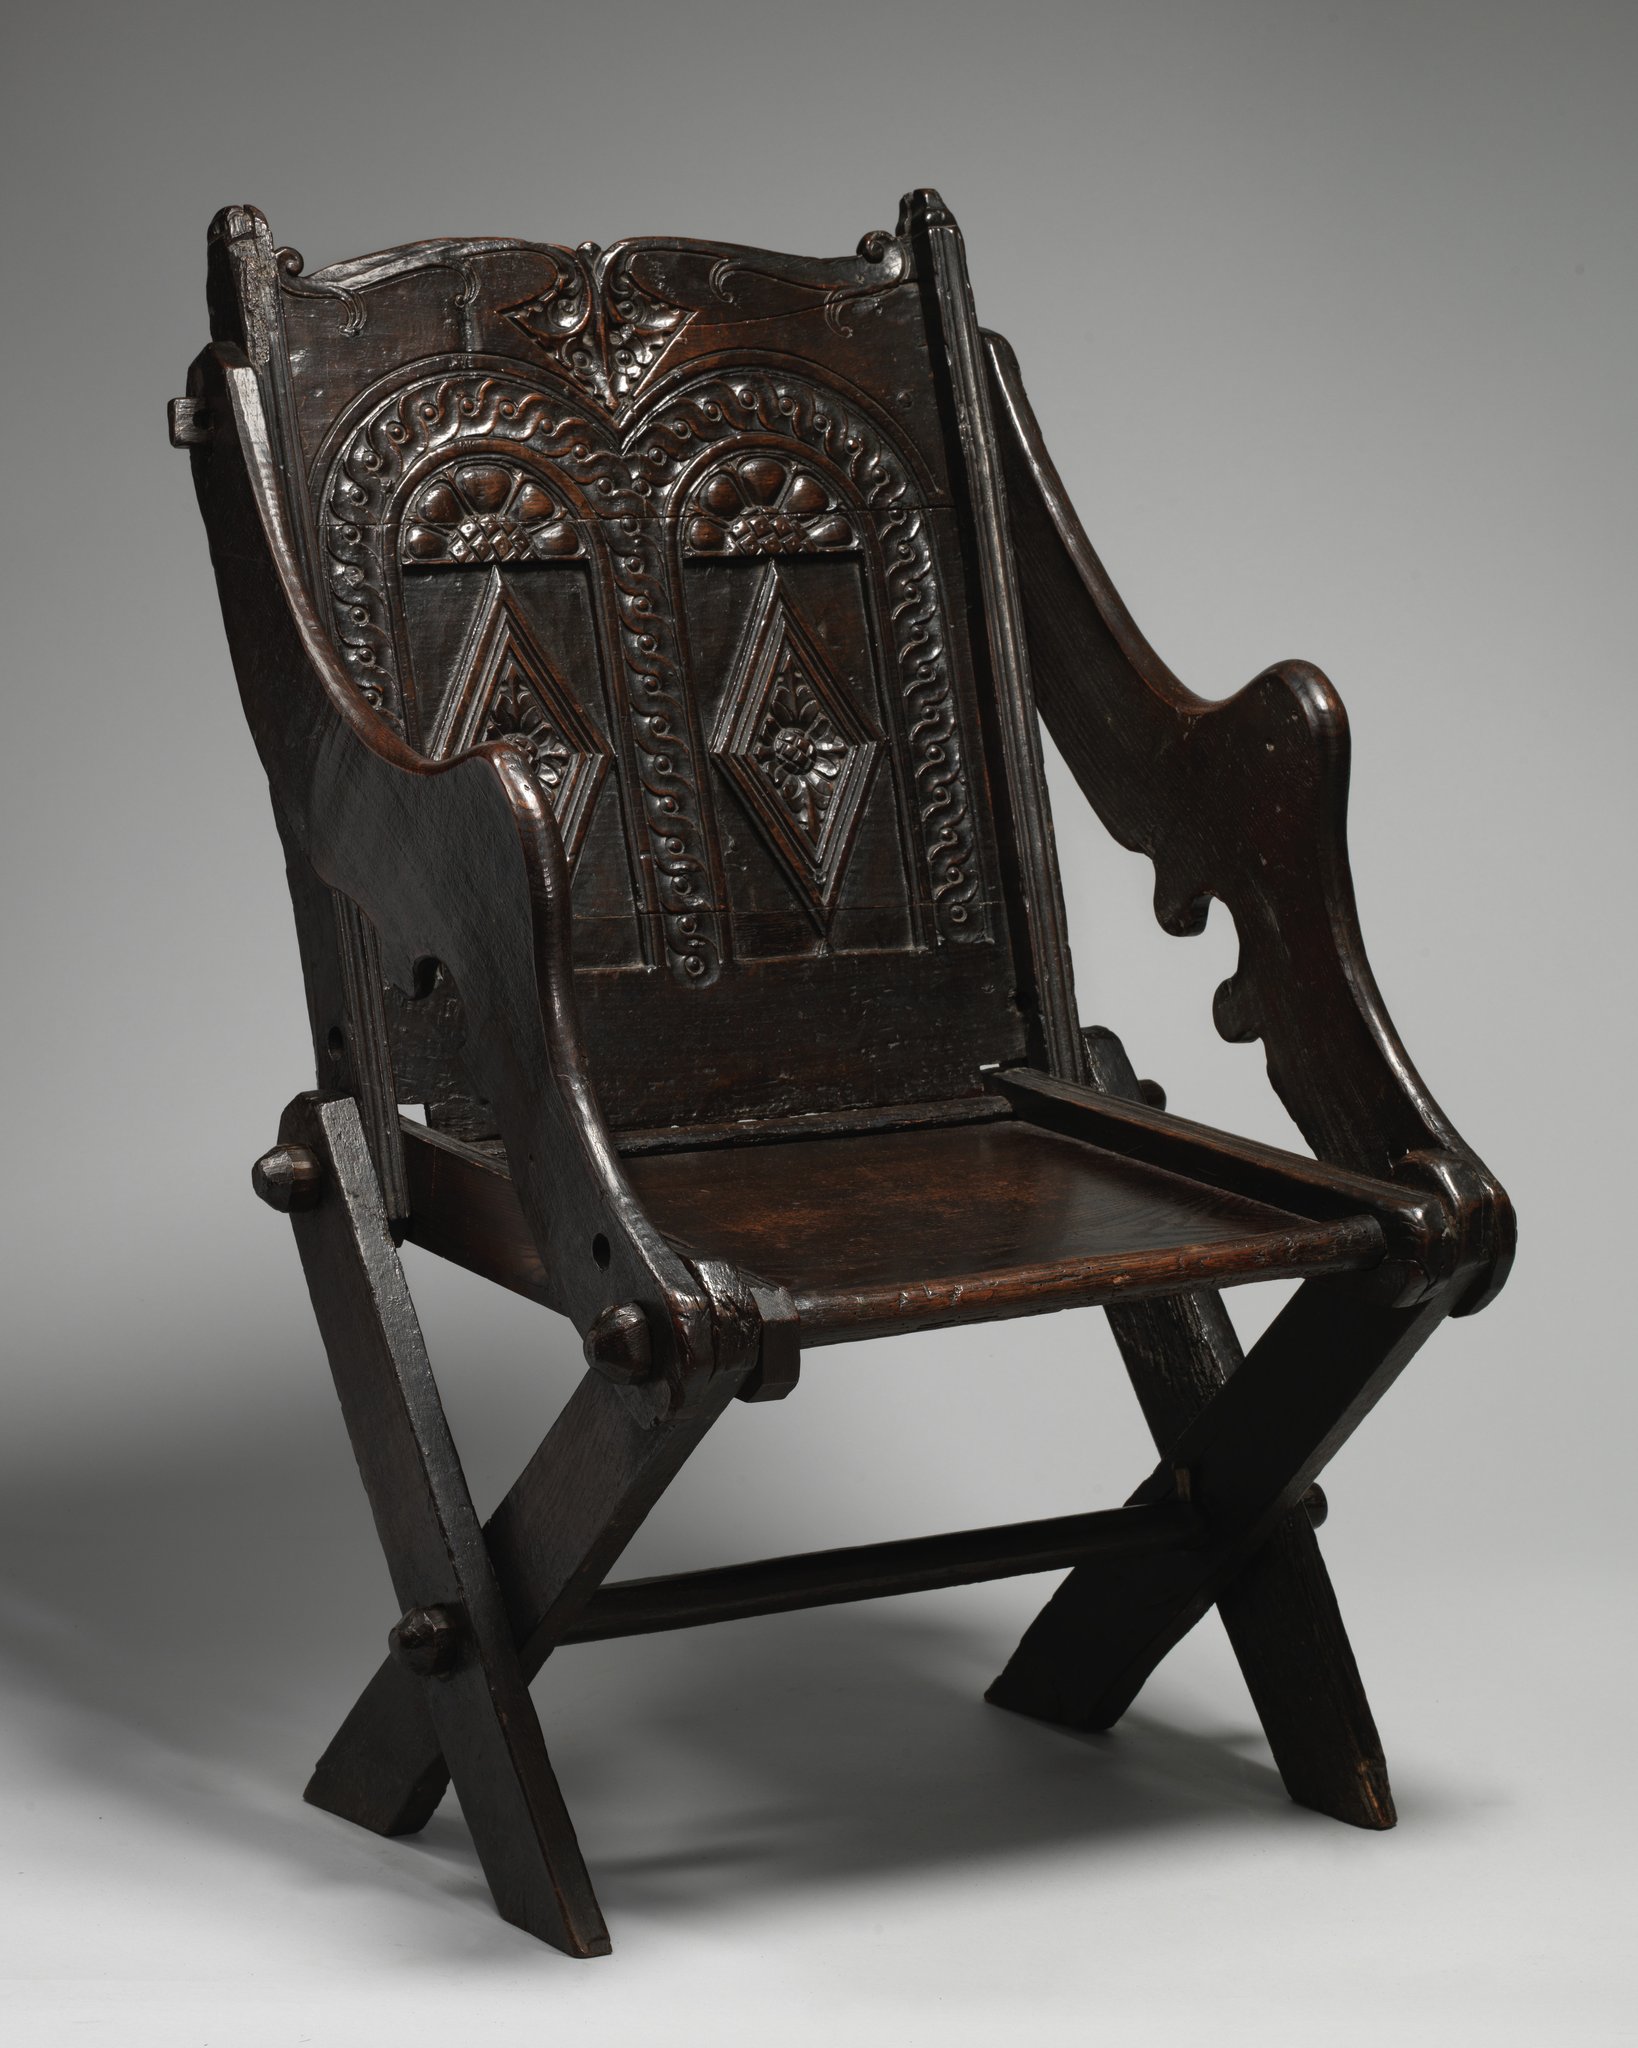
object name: folding chair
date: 1600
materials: wood